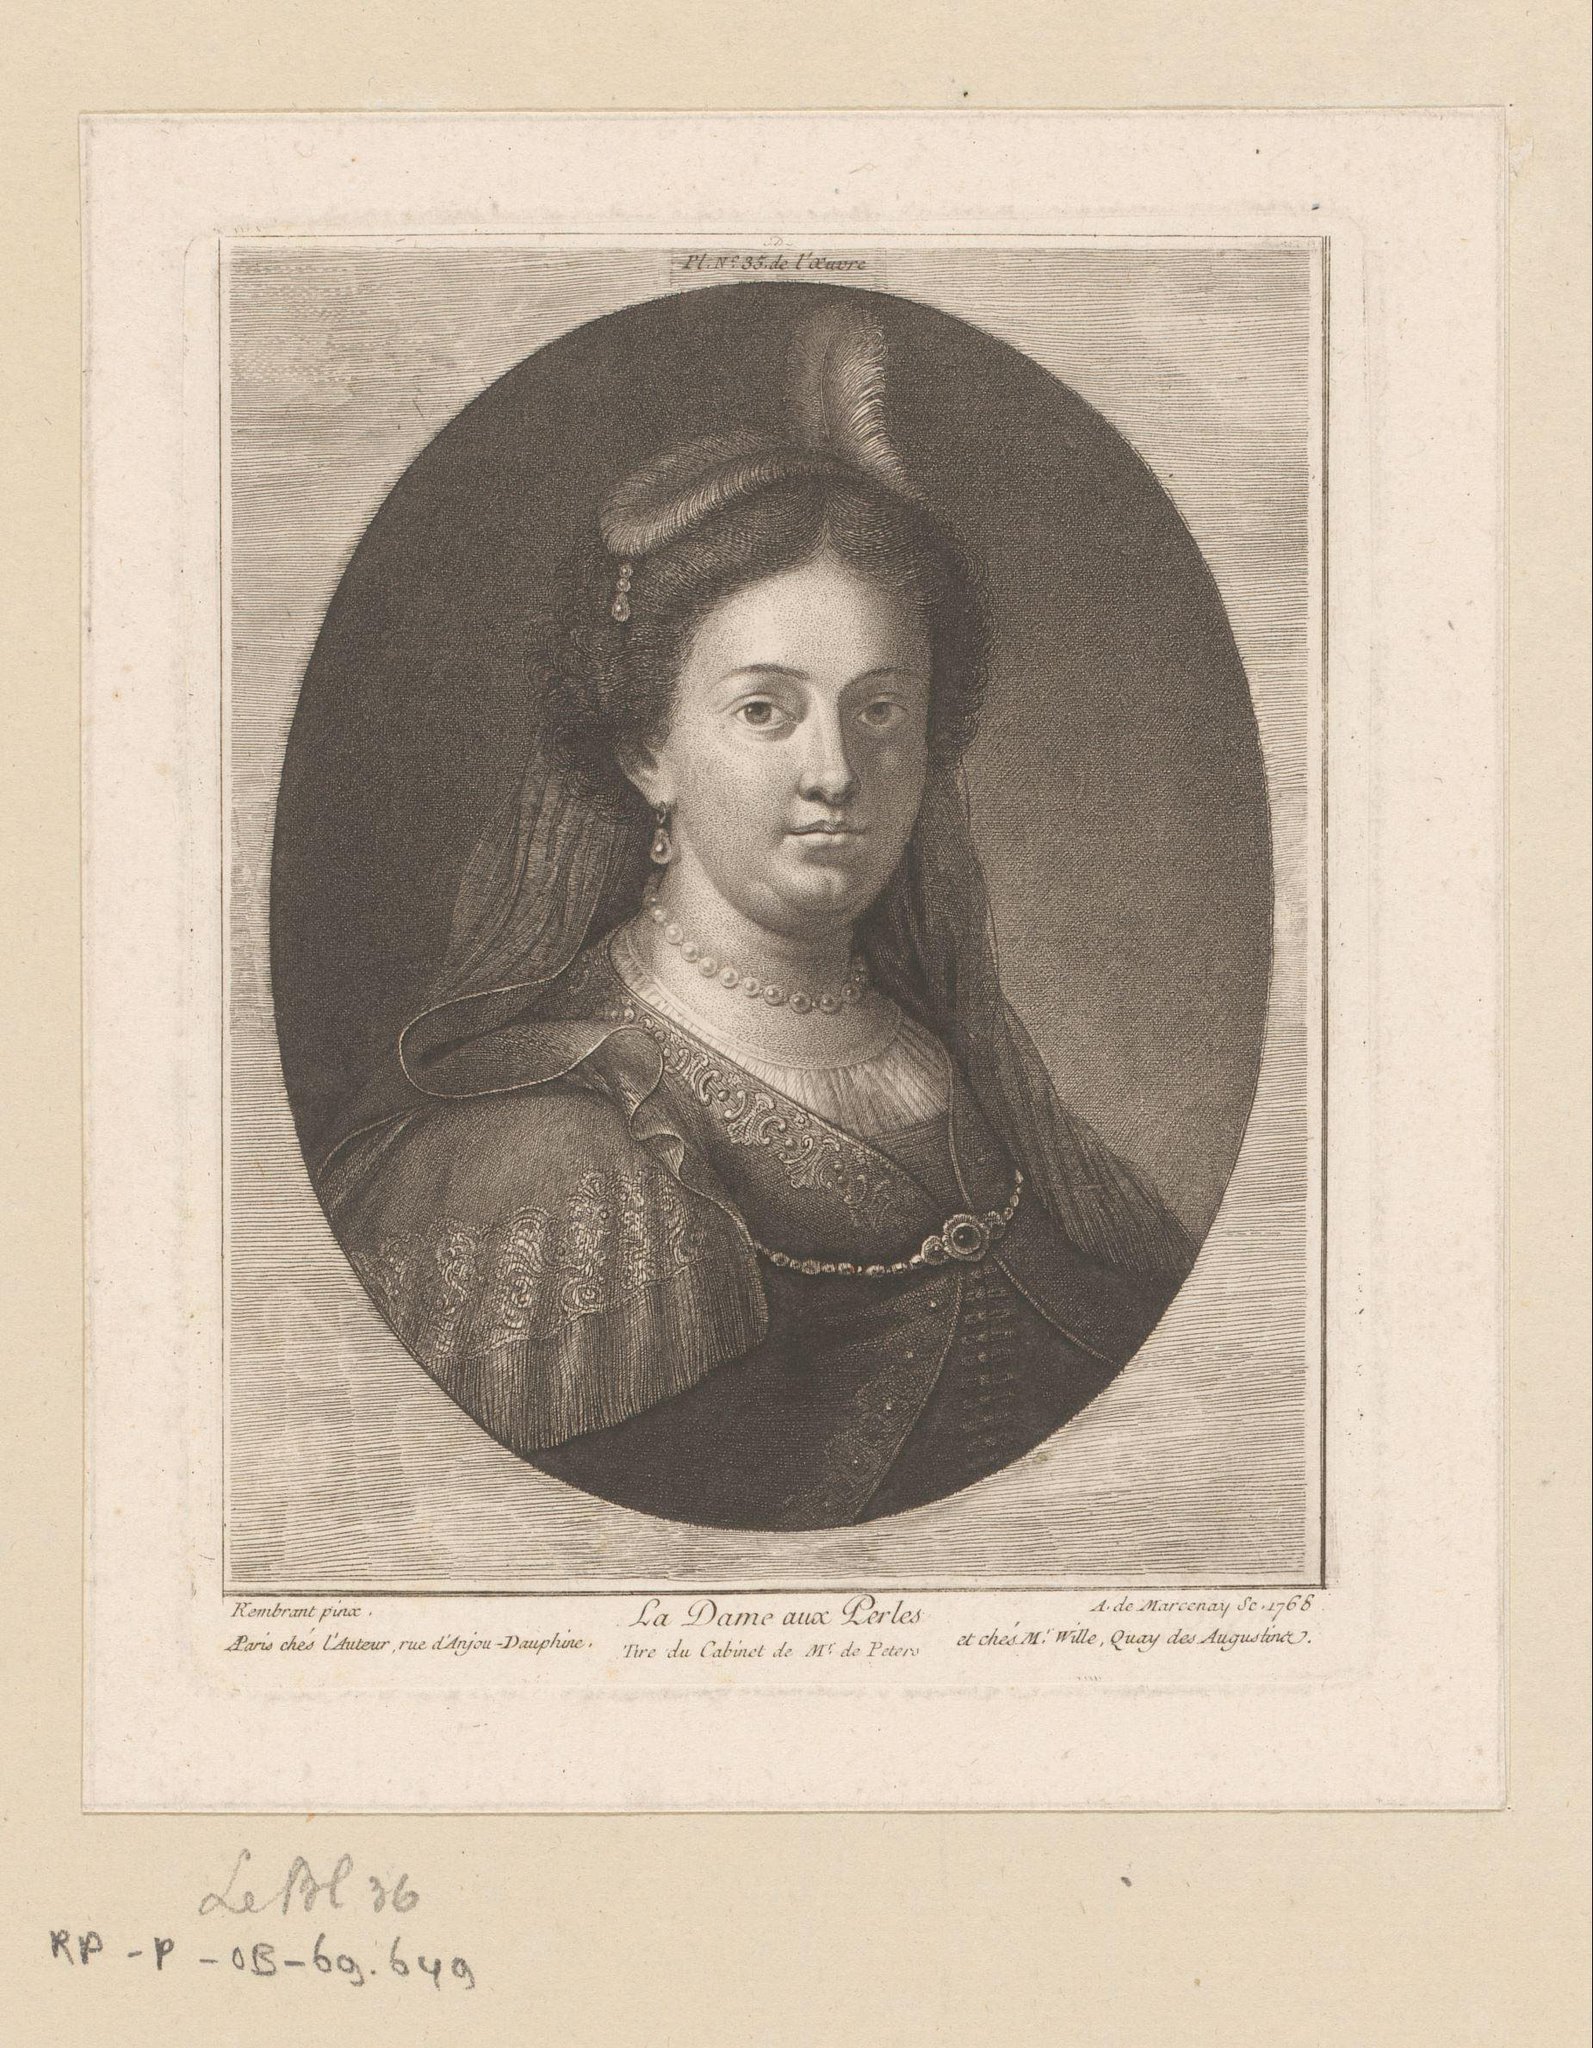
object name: print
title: La Dame aux Perles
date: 1768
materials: paper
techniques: etching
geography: paris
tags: historical persons, pearl; pearl necklace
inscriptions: collector's mark: Lugt 2228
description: Genummerd midden boven: Pl. No. 35 de l'Oeuvre.